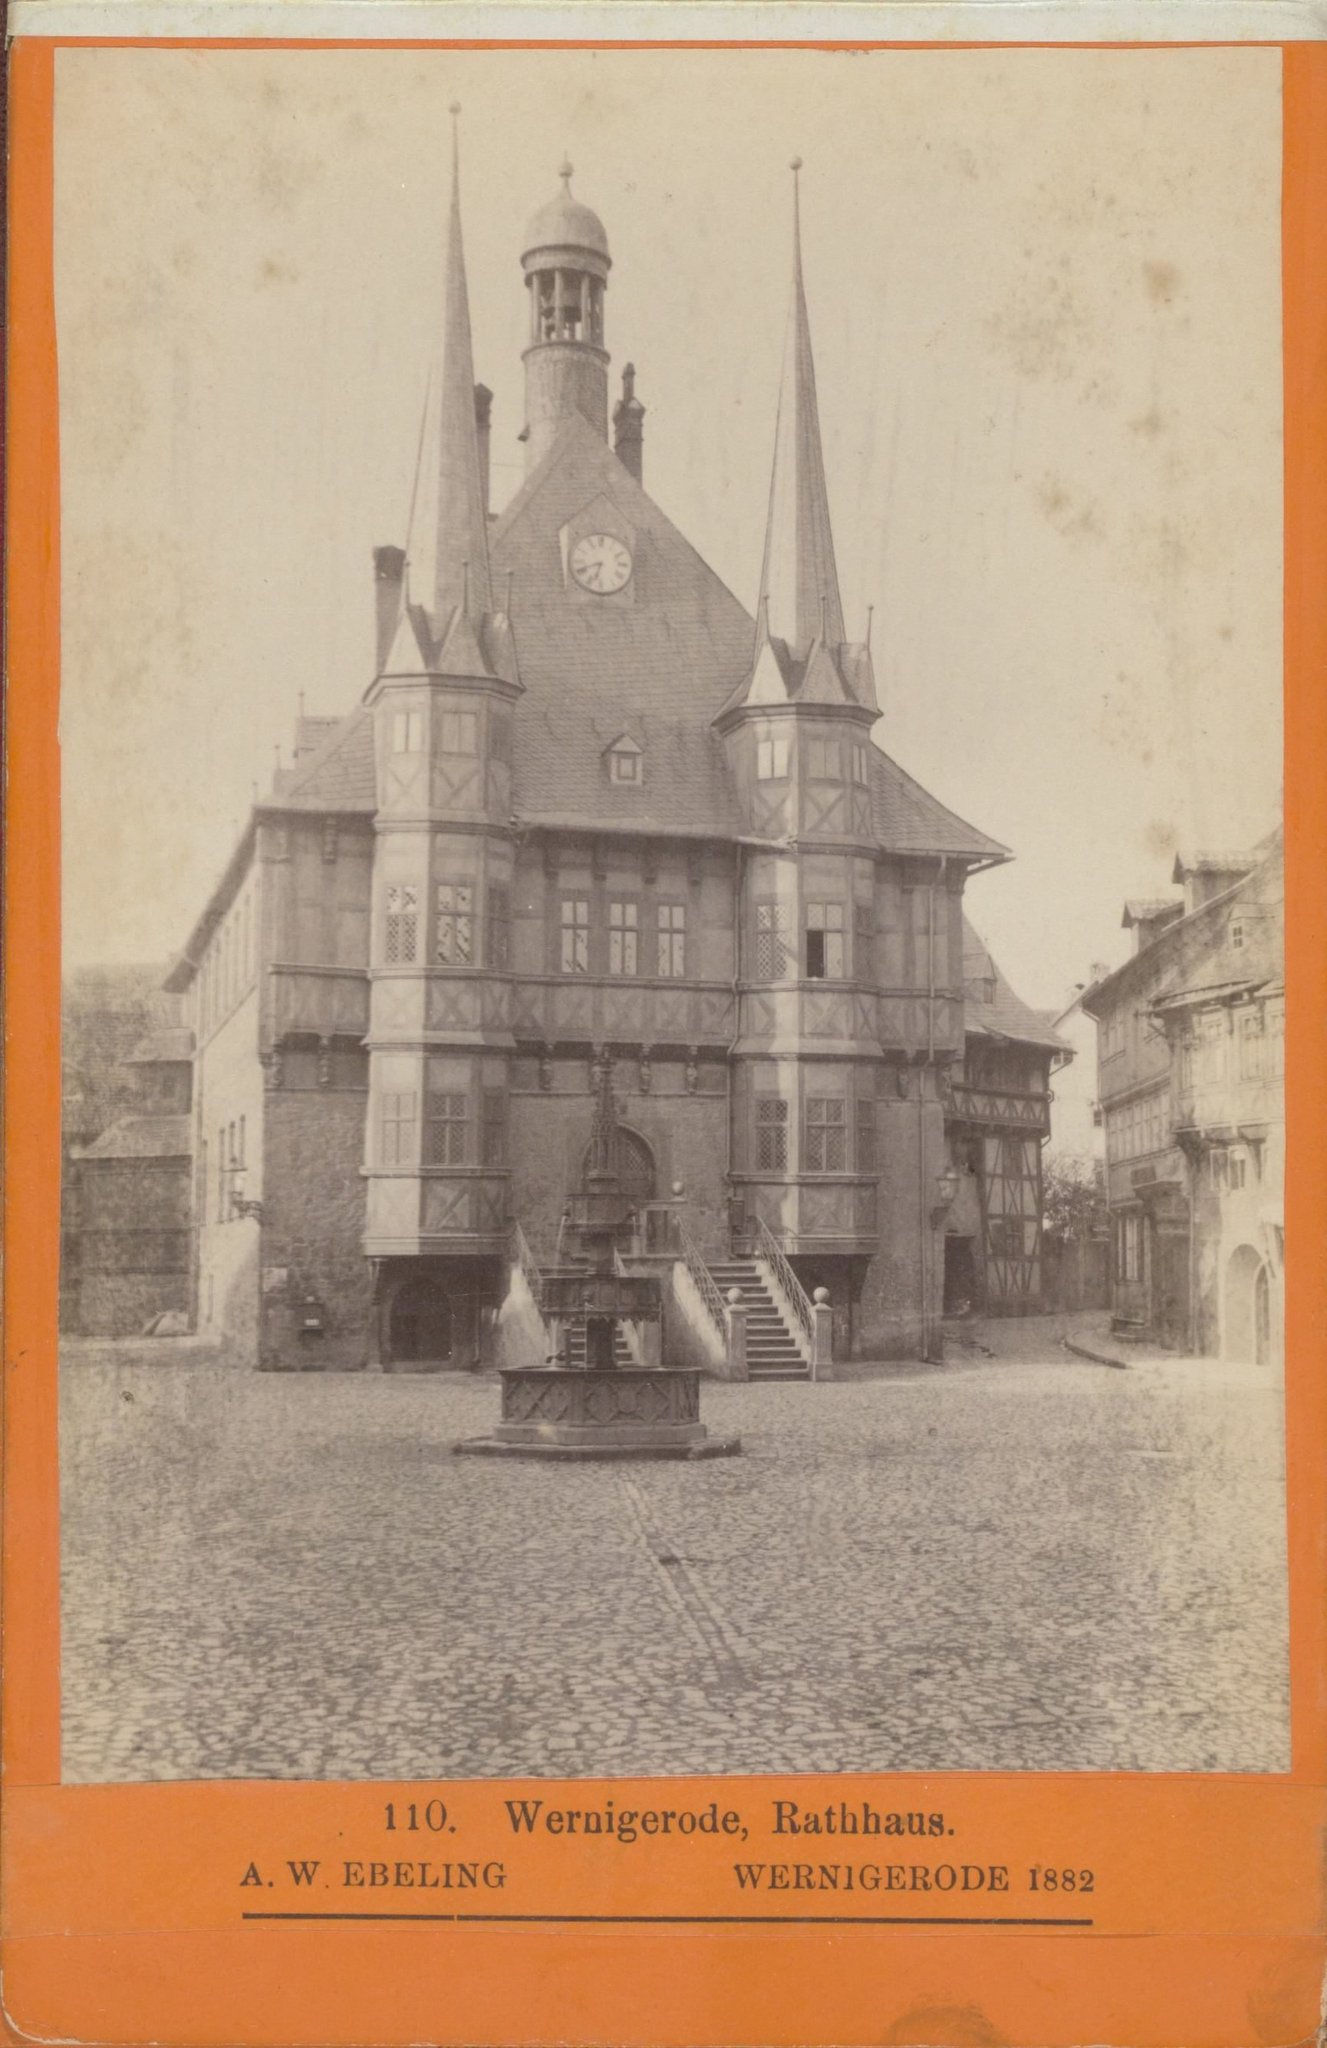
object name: cabinet photograph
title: Wernigerode, Rathaus.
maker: albert wilhelm ebeling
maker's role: fotograaf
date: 1882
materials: cardboard, paper, photographic support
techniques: albumen print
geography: wernigerode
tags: townhall, travelling; tourism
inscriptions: name: ‘Alb. Wilh. Ebeling, Wernigerode / Photographische Anstalt für Architekturen, Reproductionen u. Landcshaften.’, number: ‘110’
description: Onderdeel van Album met 38 foto's van een reis door de Harz.